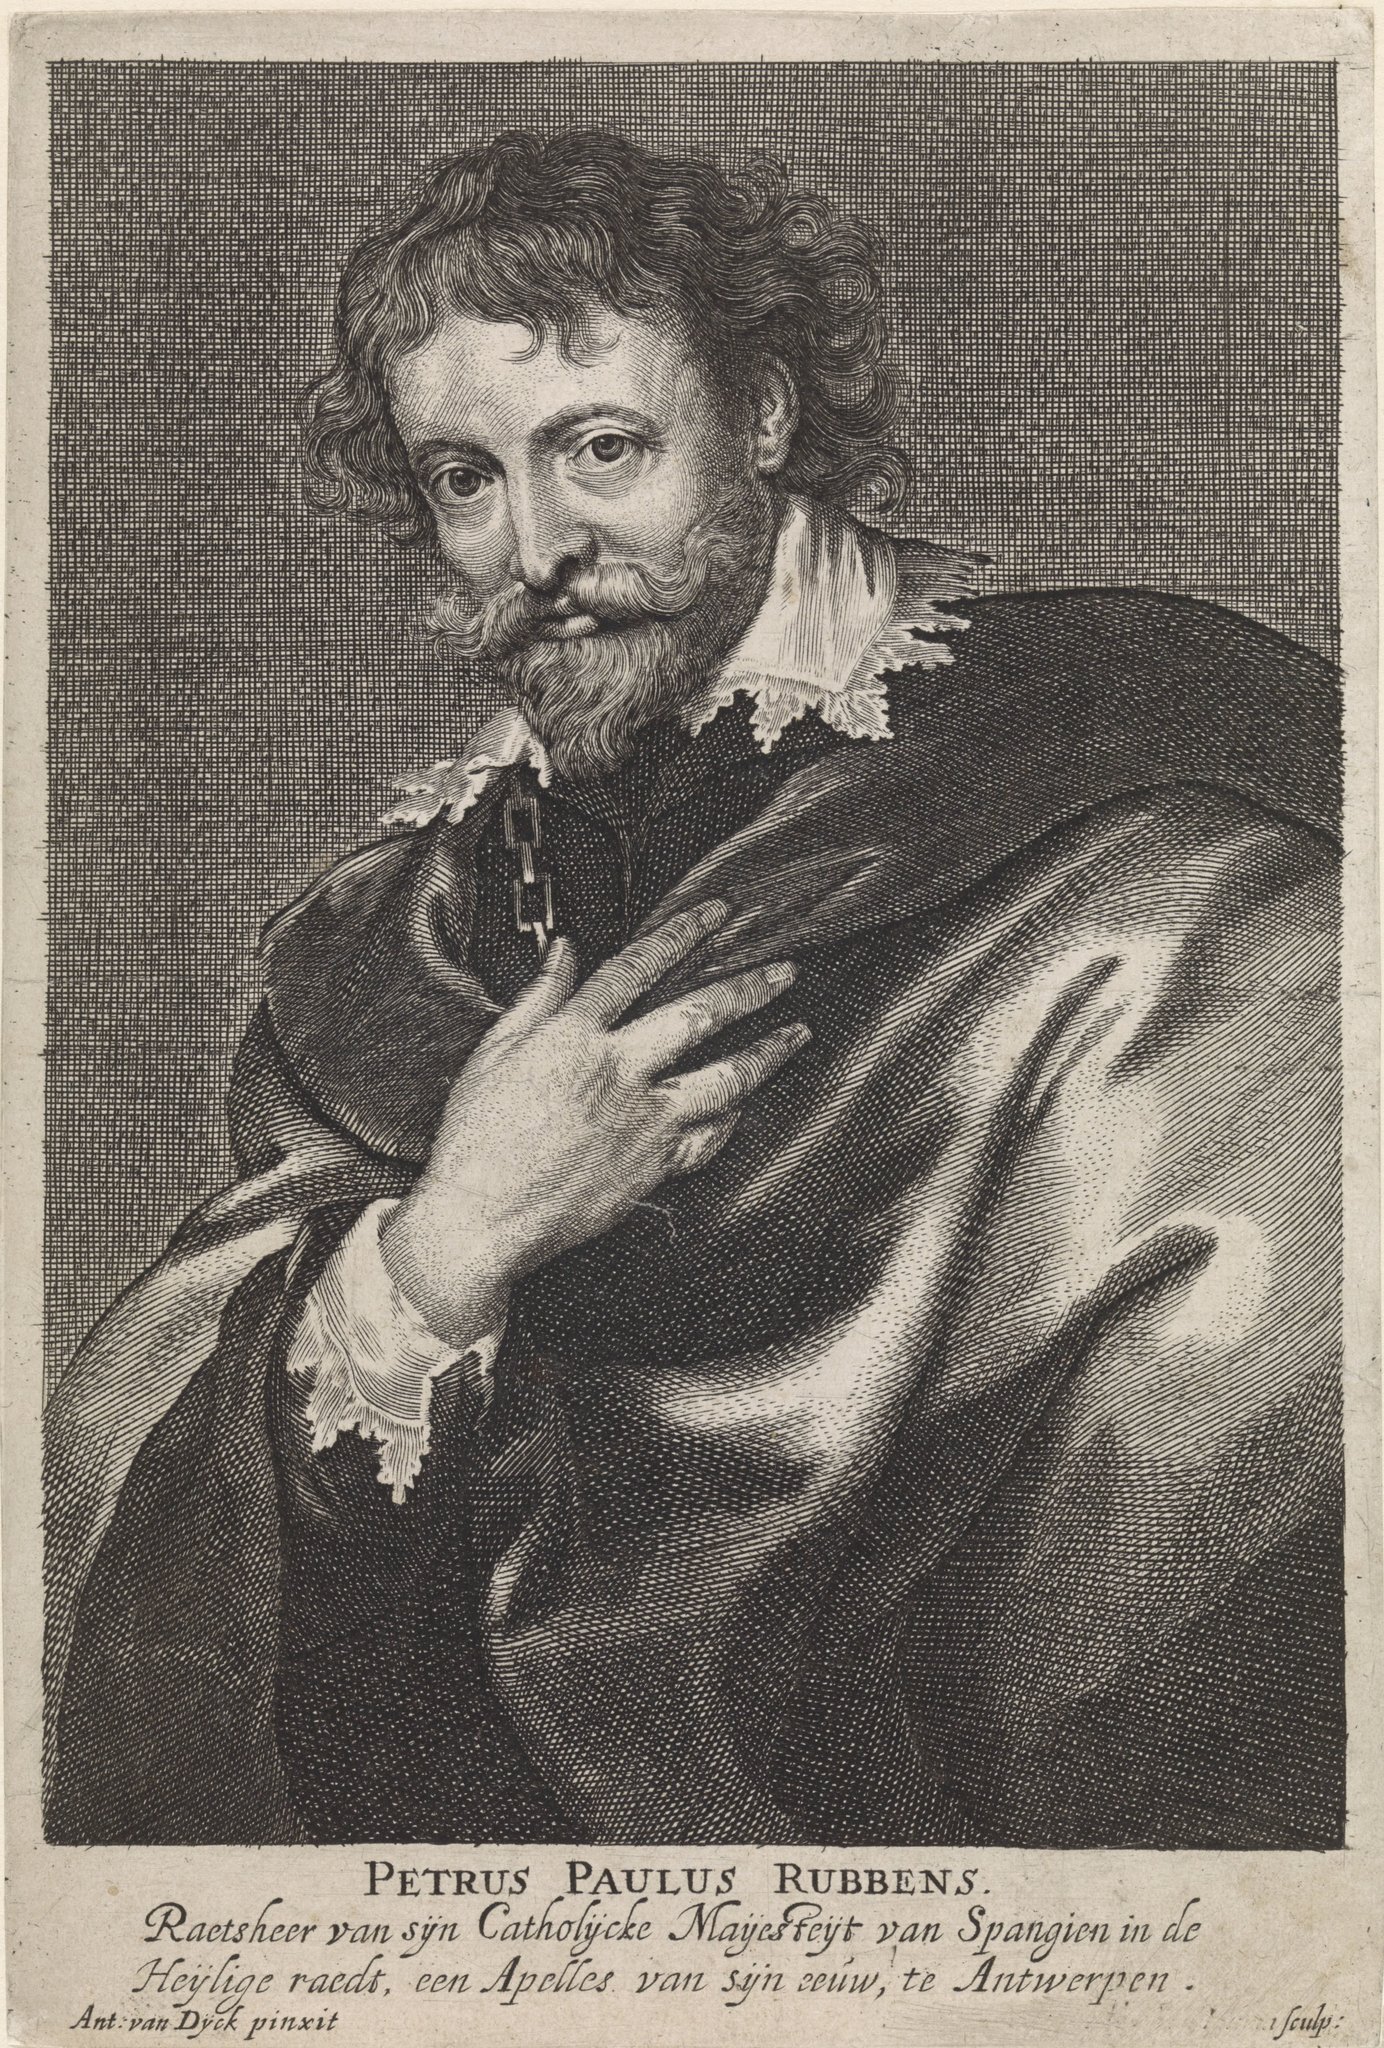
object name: print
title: Portret van Peter Paul Rubens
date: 1650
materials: paper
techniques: engraving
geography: amsterdam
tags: antwerp, painter, print maker, draughtsman, peter paul rubens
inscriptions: collector's mark: Lugt 2228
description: Portret van de kunstenaar en diplomaat Peter Paul Rubens.